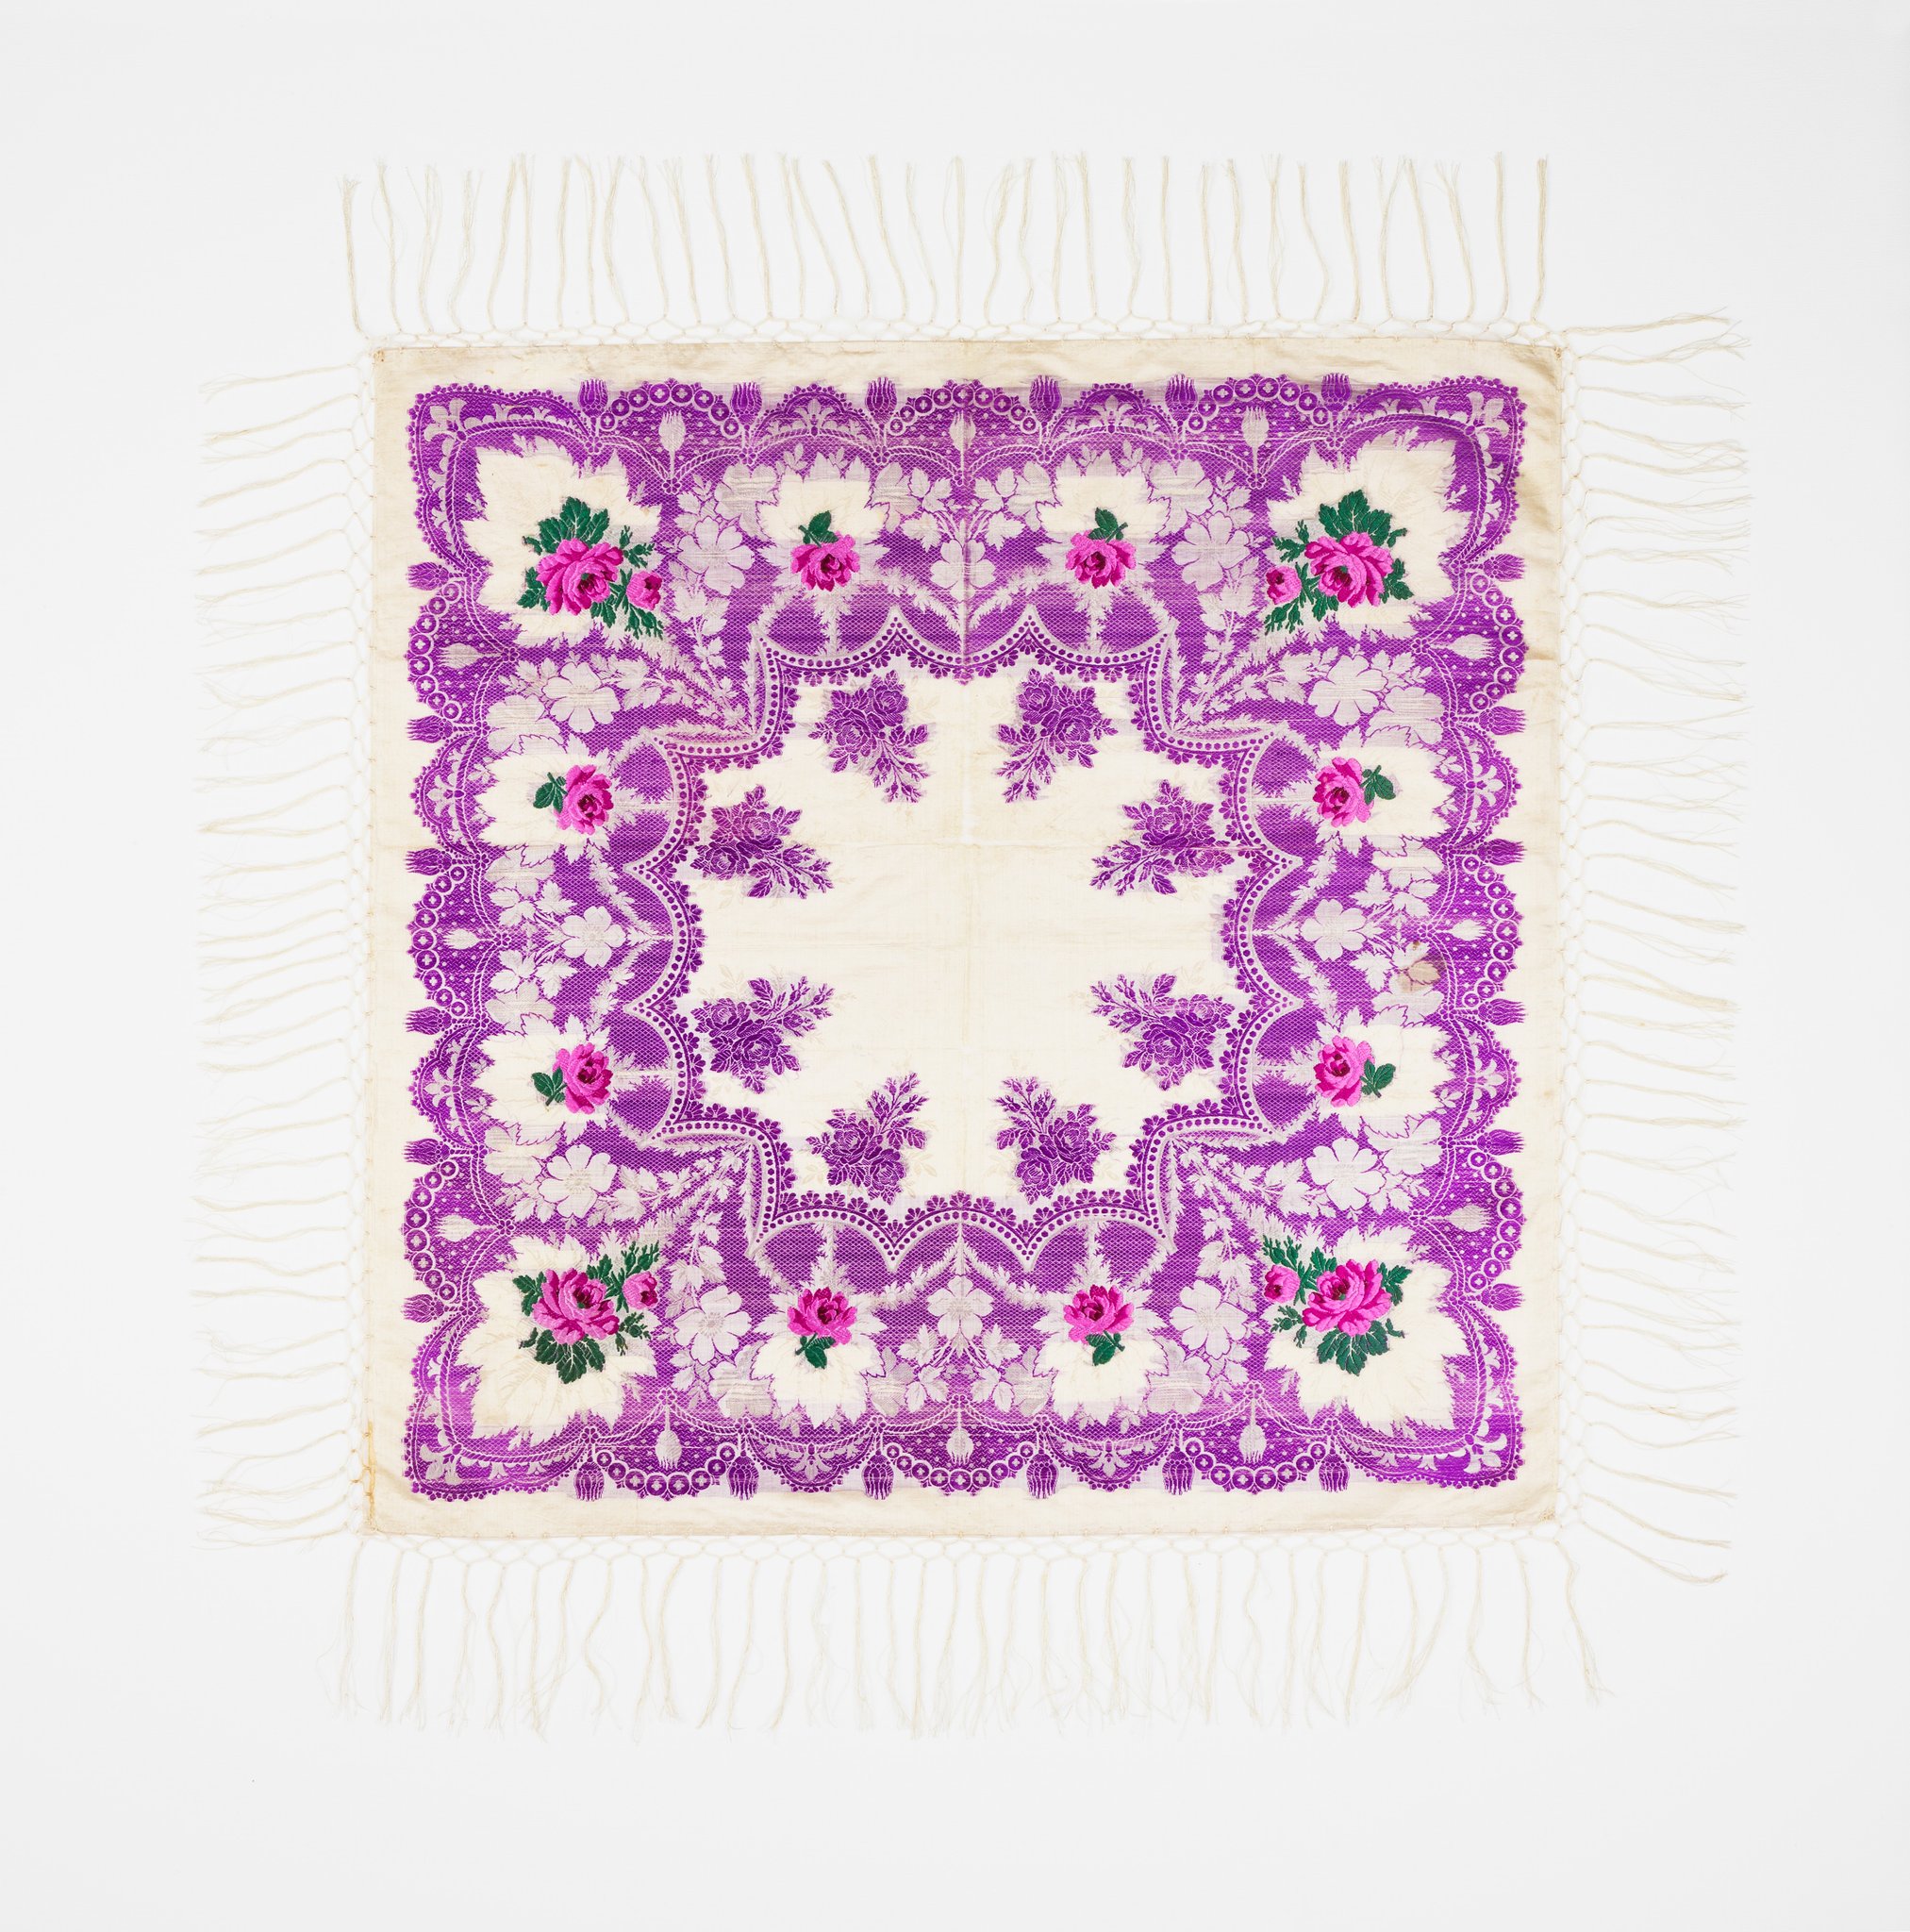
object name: scarf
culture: european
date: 1860-1890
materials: silk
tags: roses